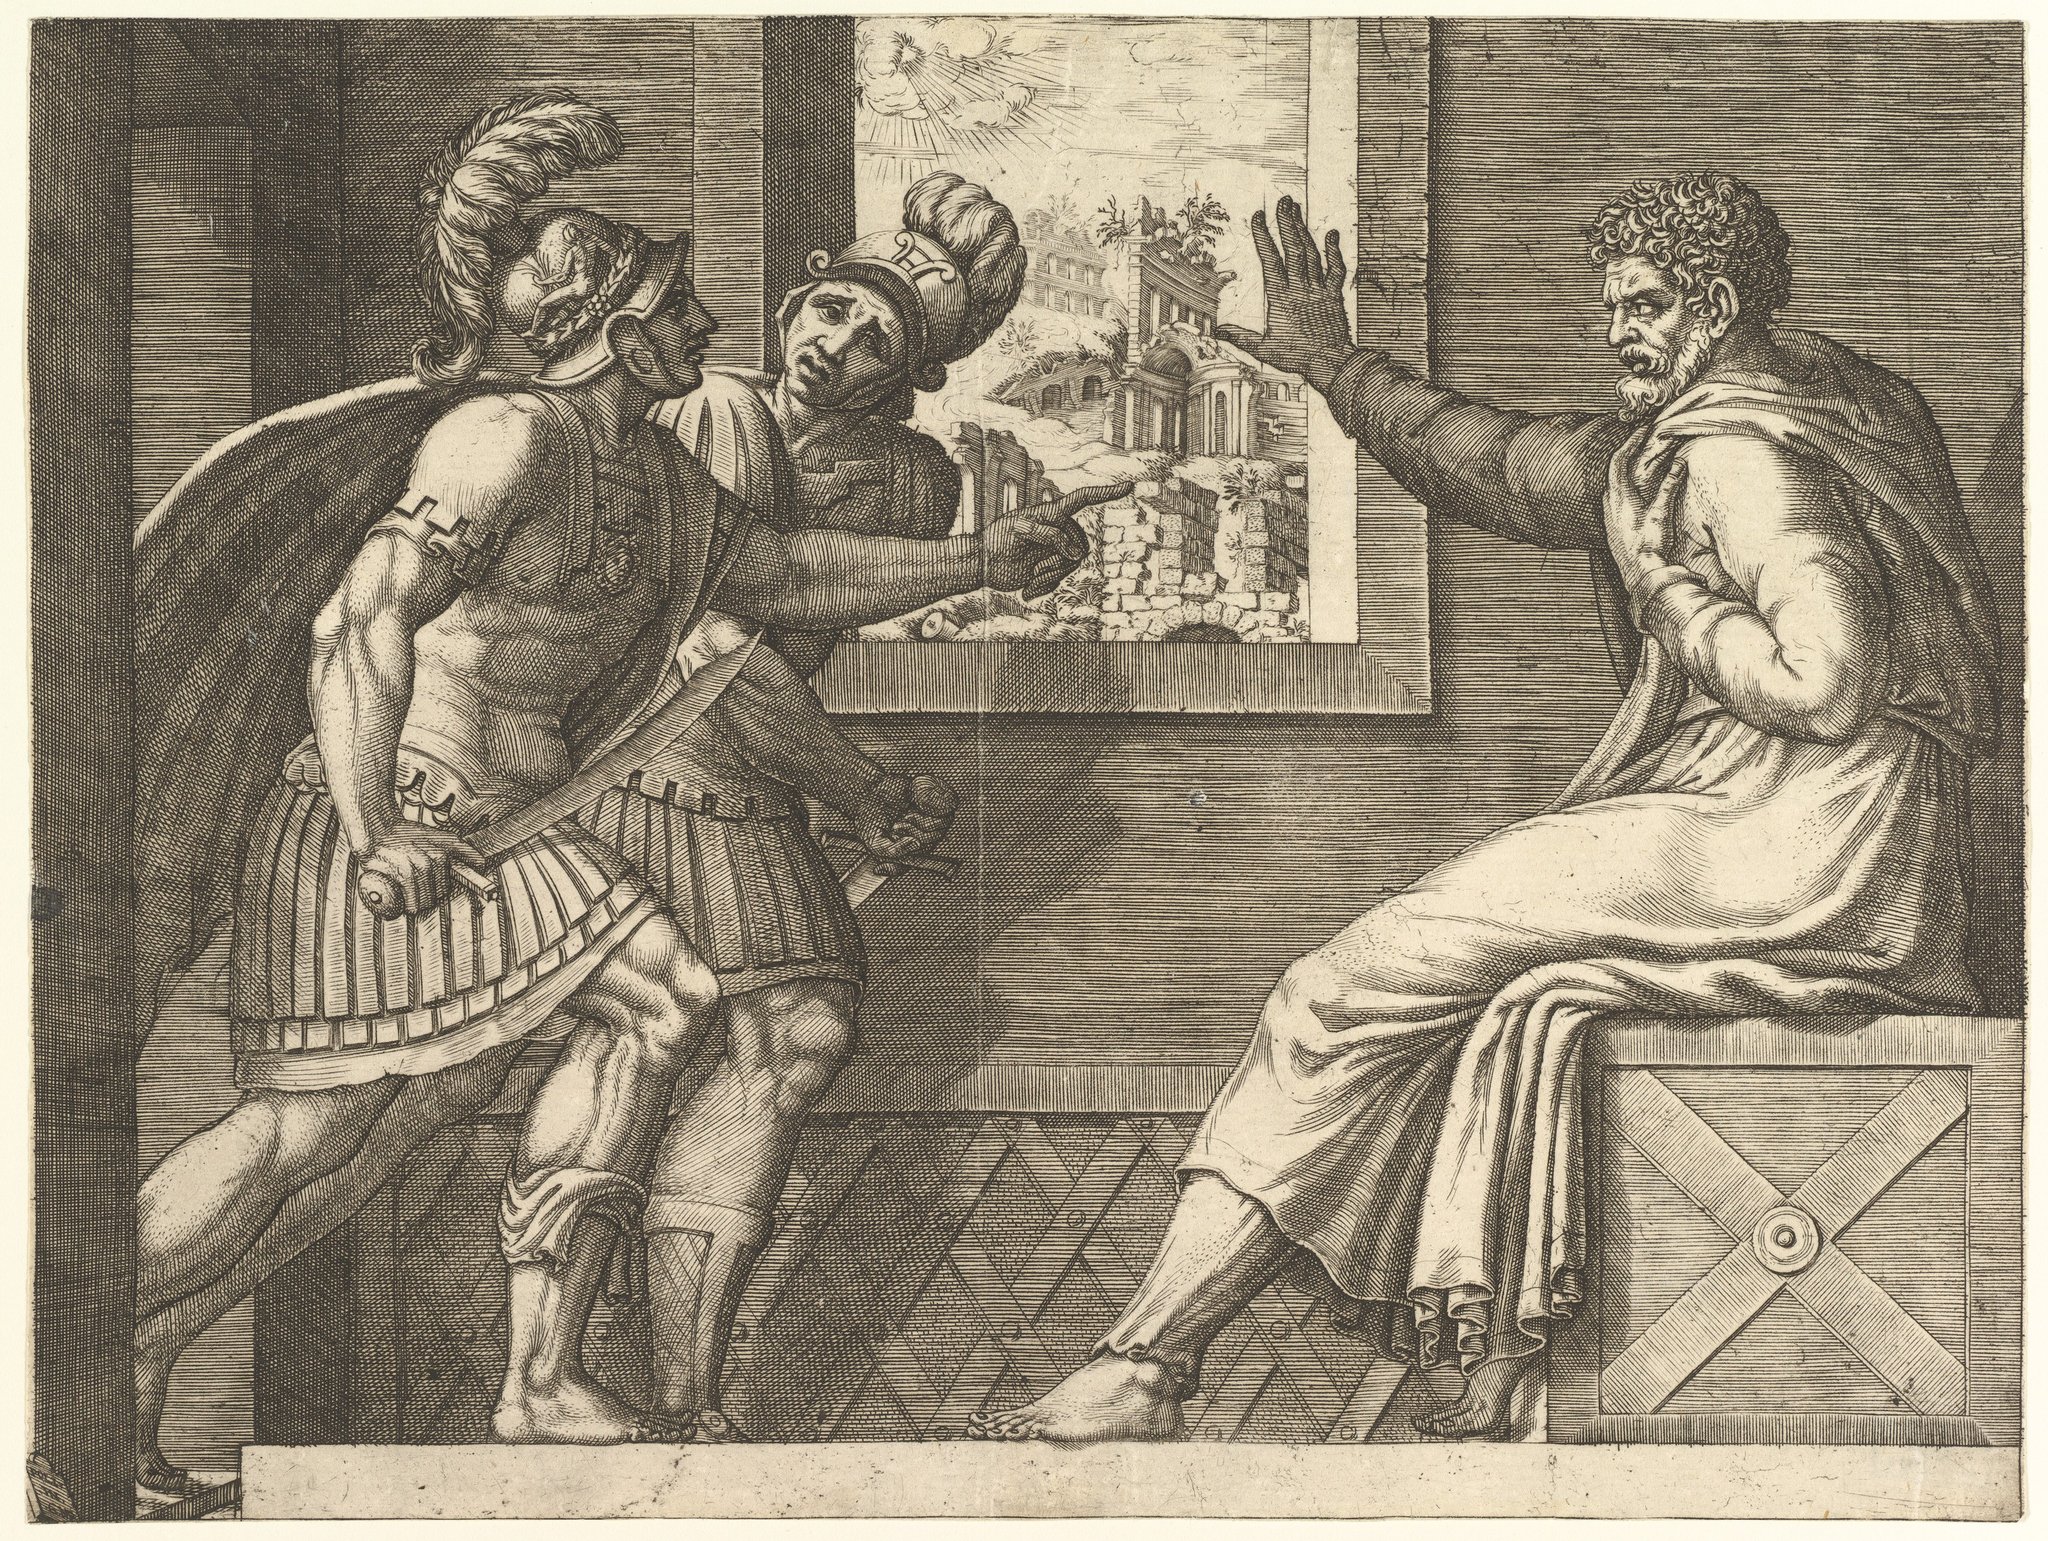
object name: print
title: Caius Marius in Prison, two Cimbrian soldiers entering his cell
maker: giorgio ghisi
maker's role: artist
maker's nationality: italian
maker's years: 1515-1582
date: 1560-1569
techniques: engraving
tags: prisons,soldiers,prisoners,men,generals